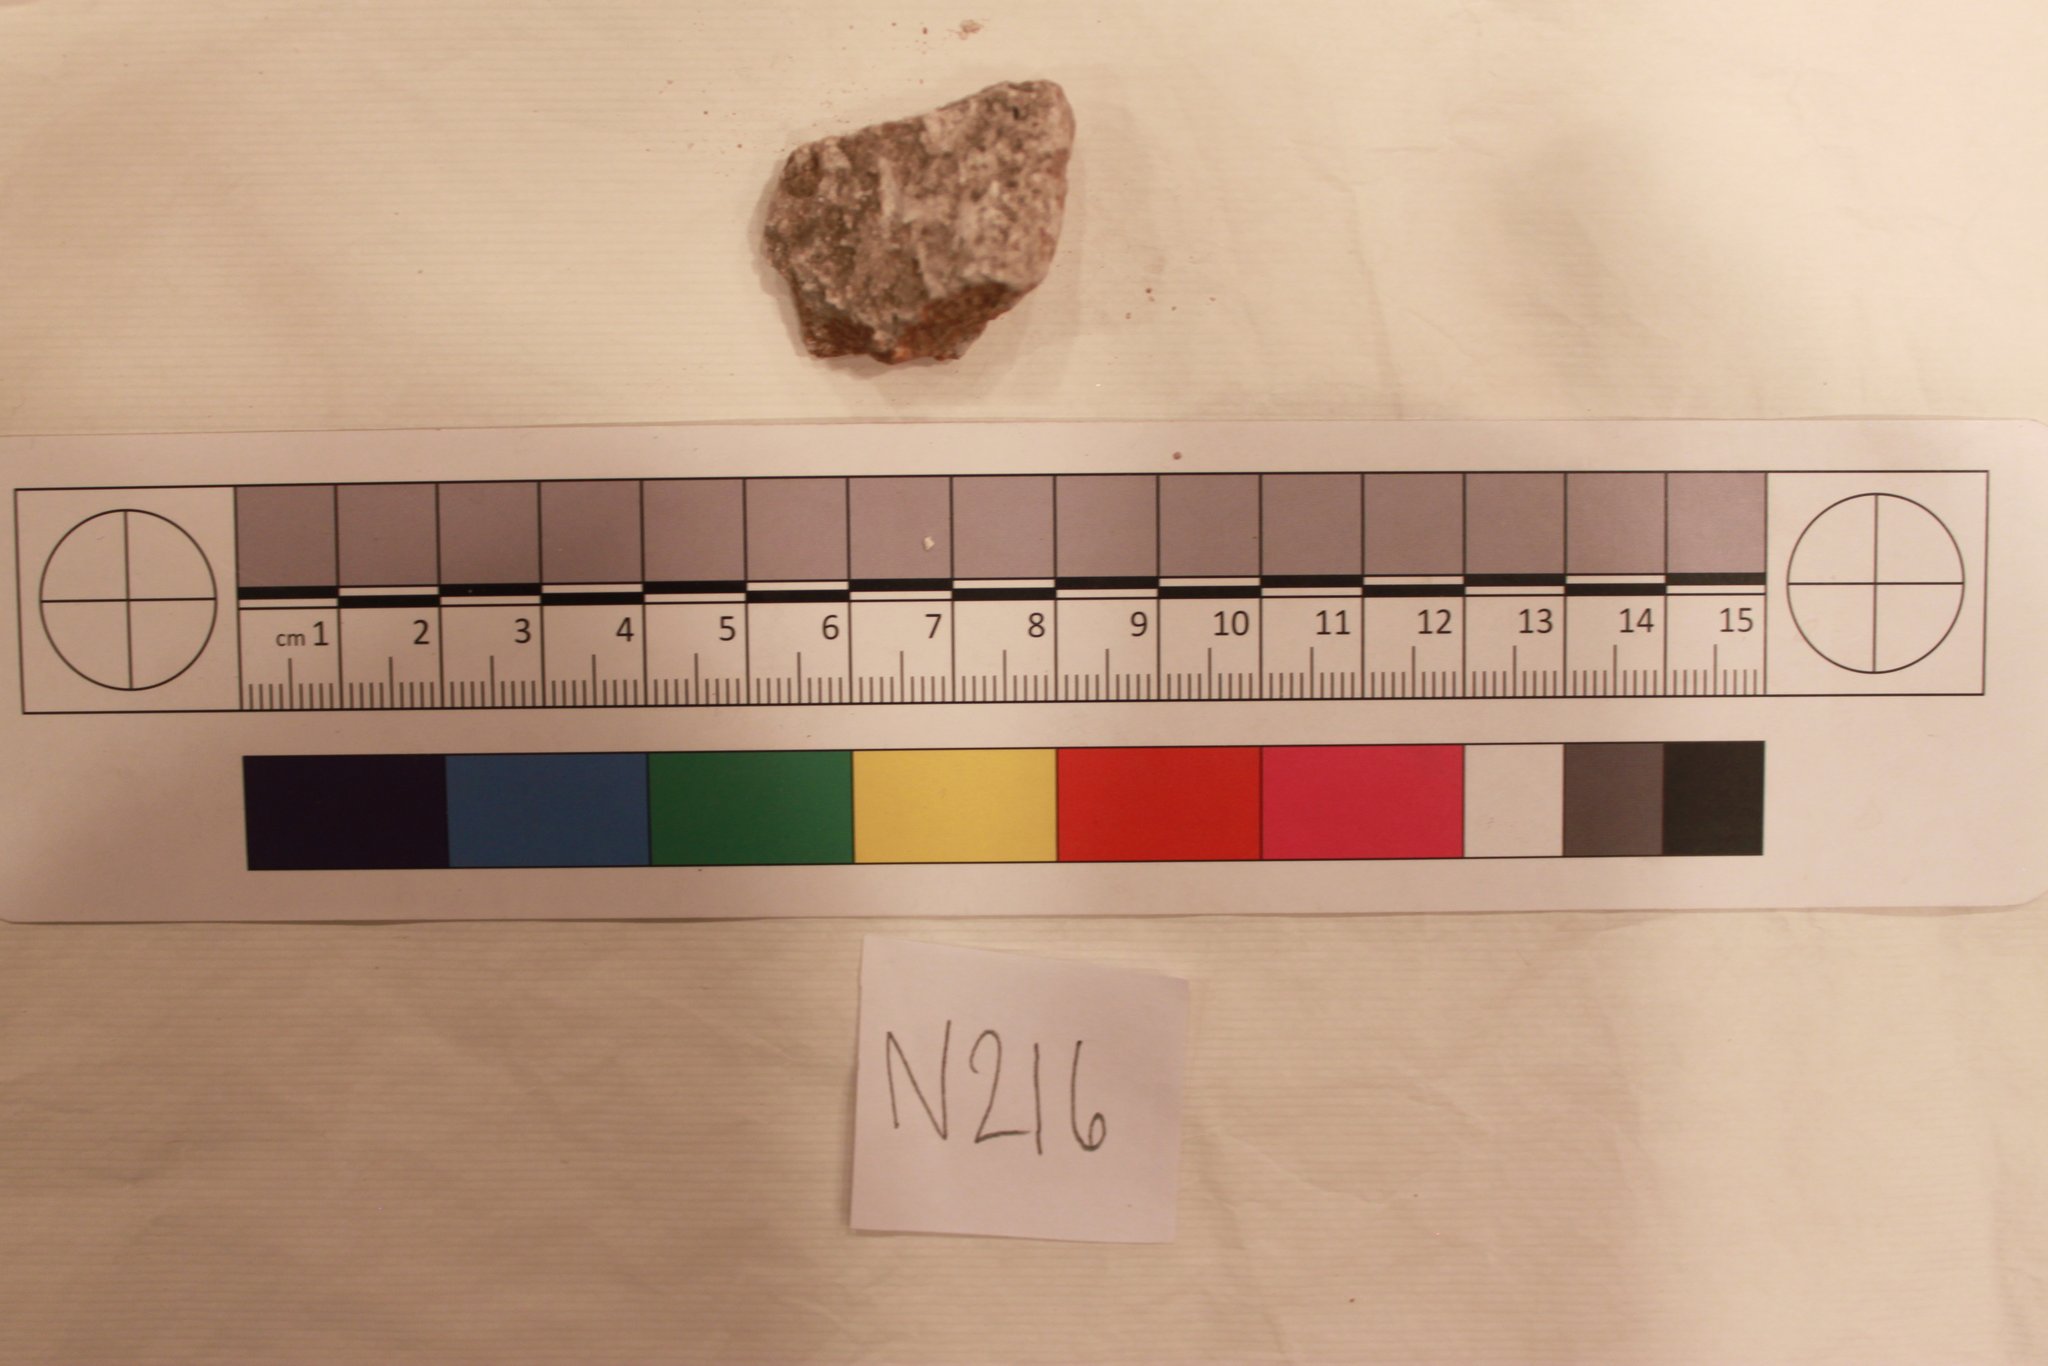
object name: fragment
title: Stucco Fragment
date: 701-1200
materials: plaster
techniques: carving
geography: iran